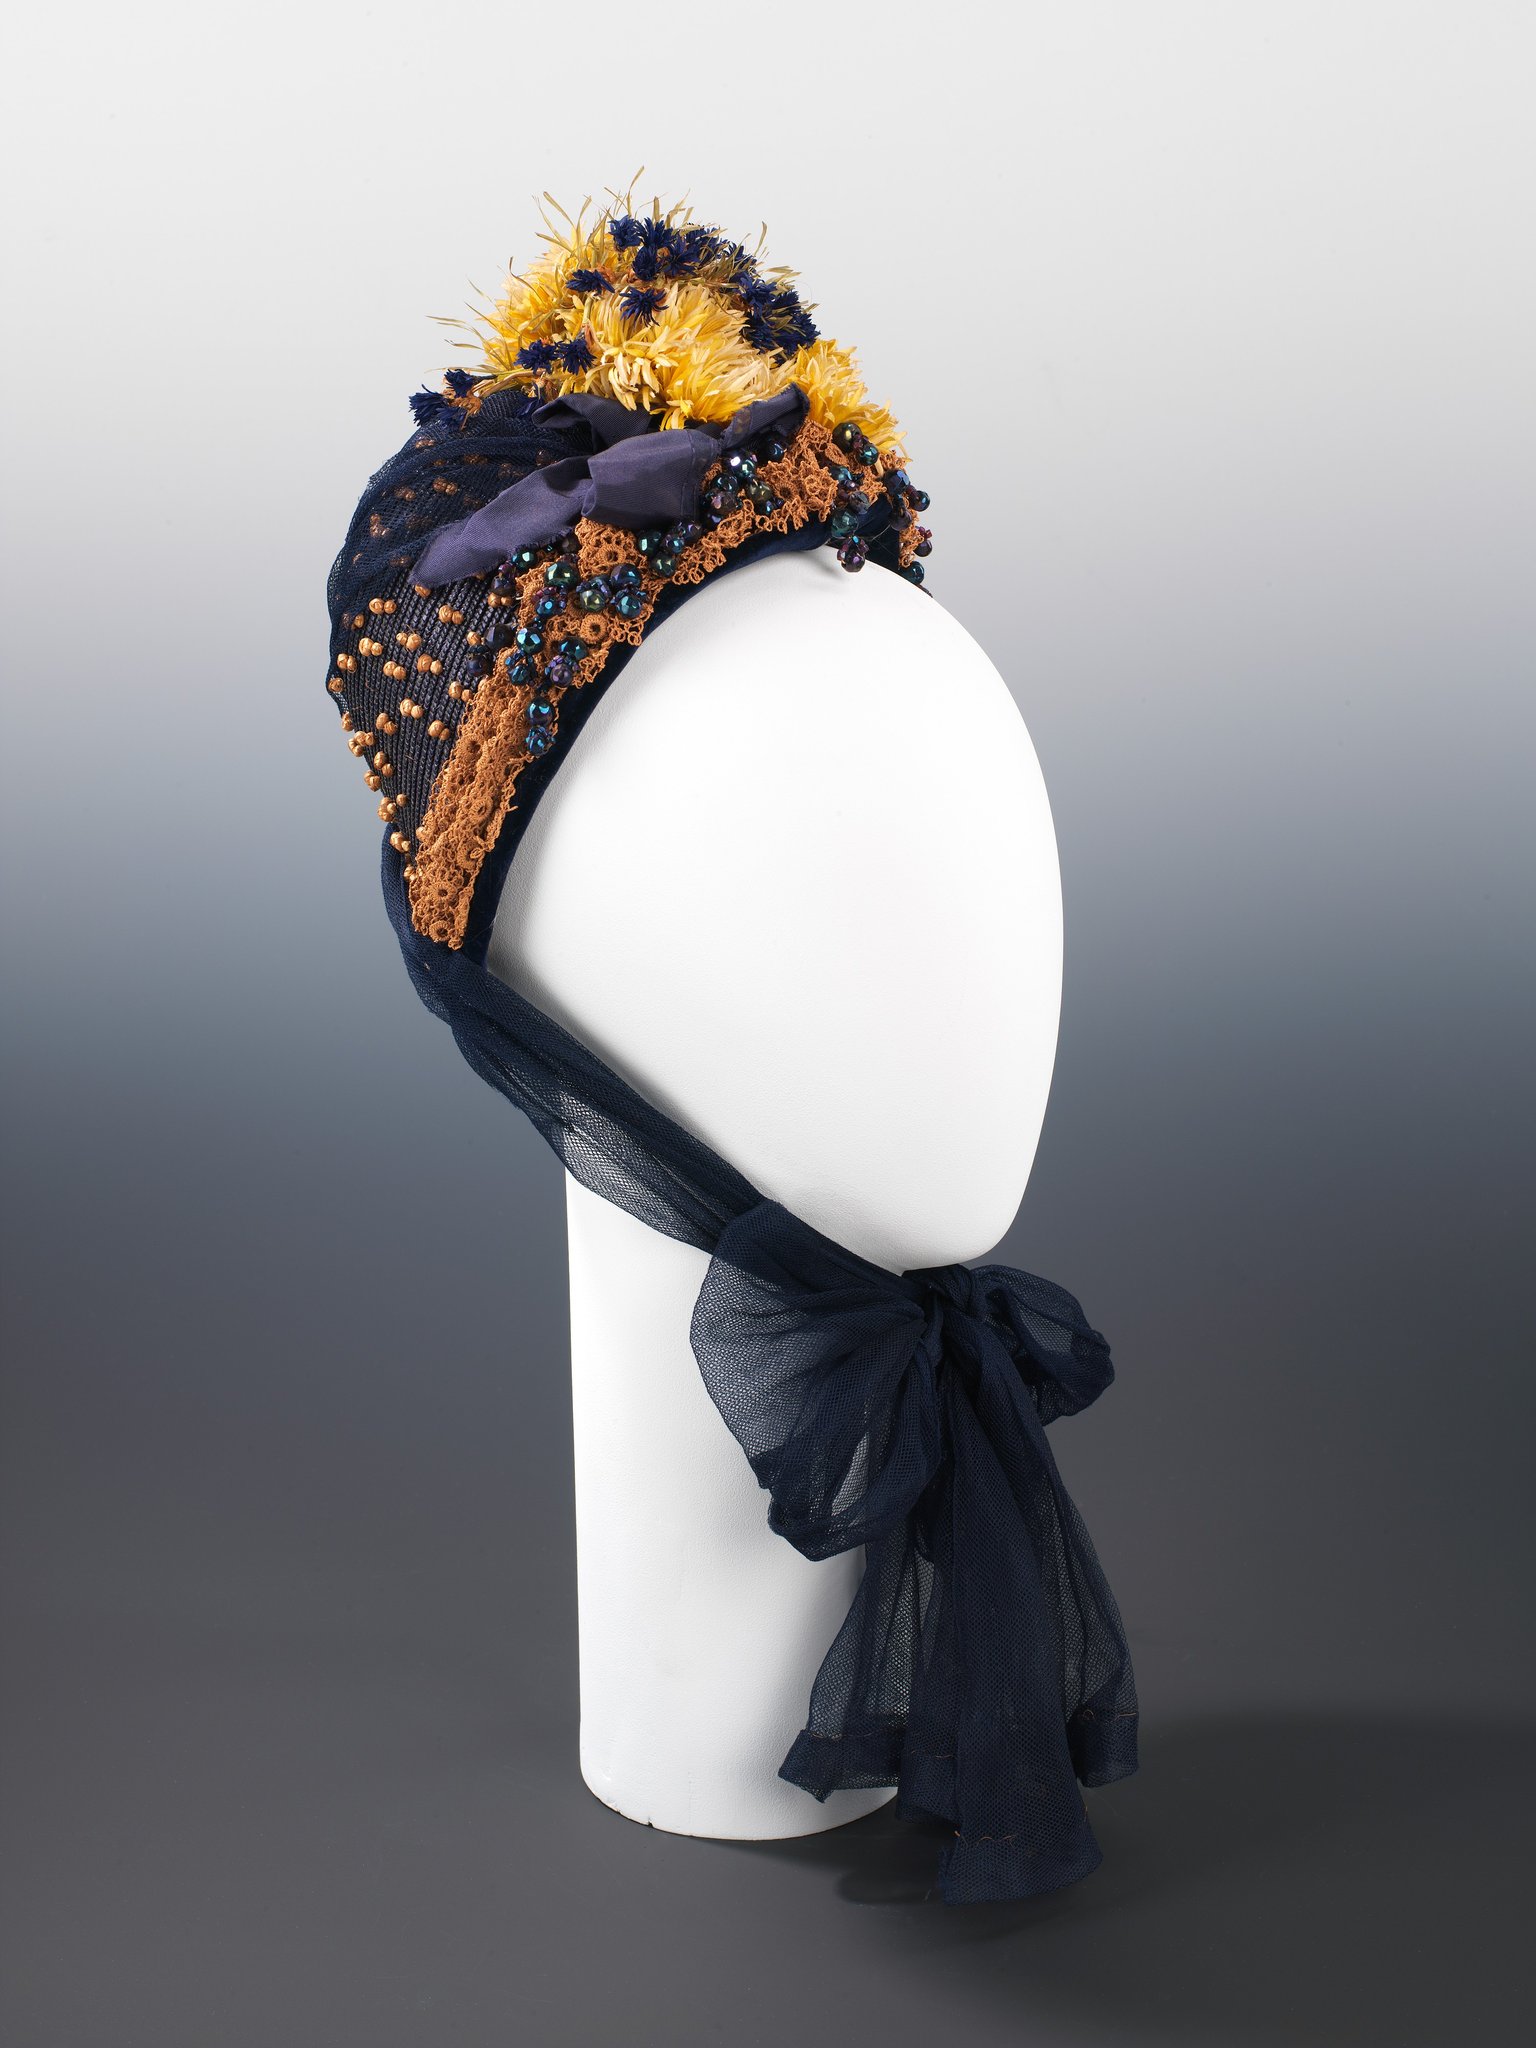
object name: bonnet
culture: american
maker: aitken son & company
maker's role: designer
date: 1885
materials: silk, fiber